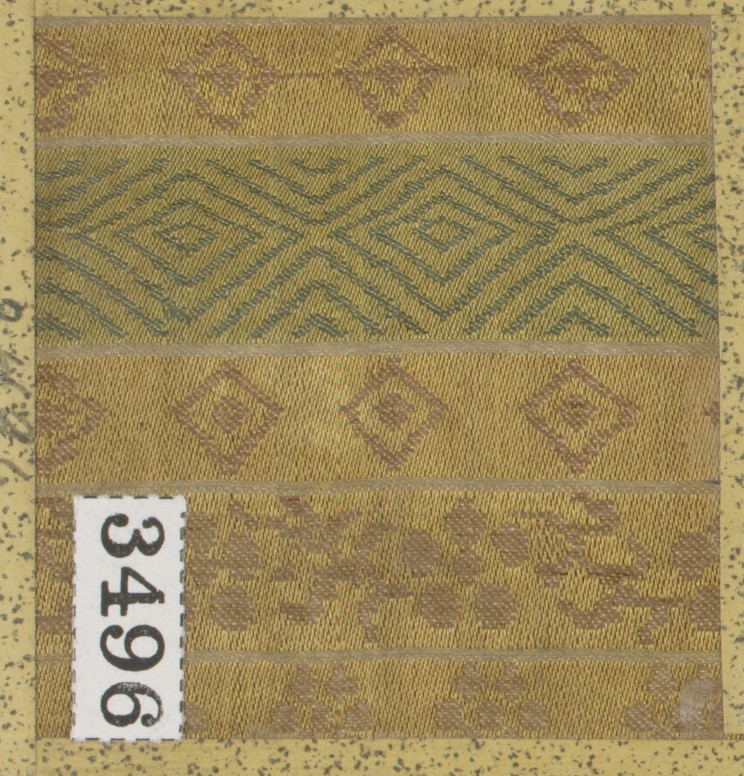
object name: sample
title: Textile Sample from Sample Book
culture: japanese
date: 1801-1900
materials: silk